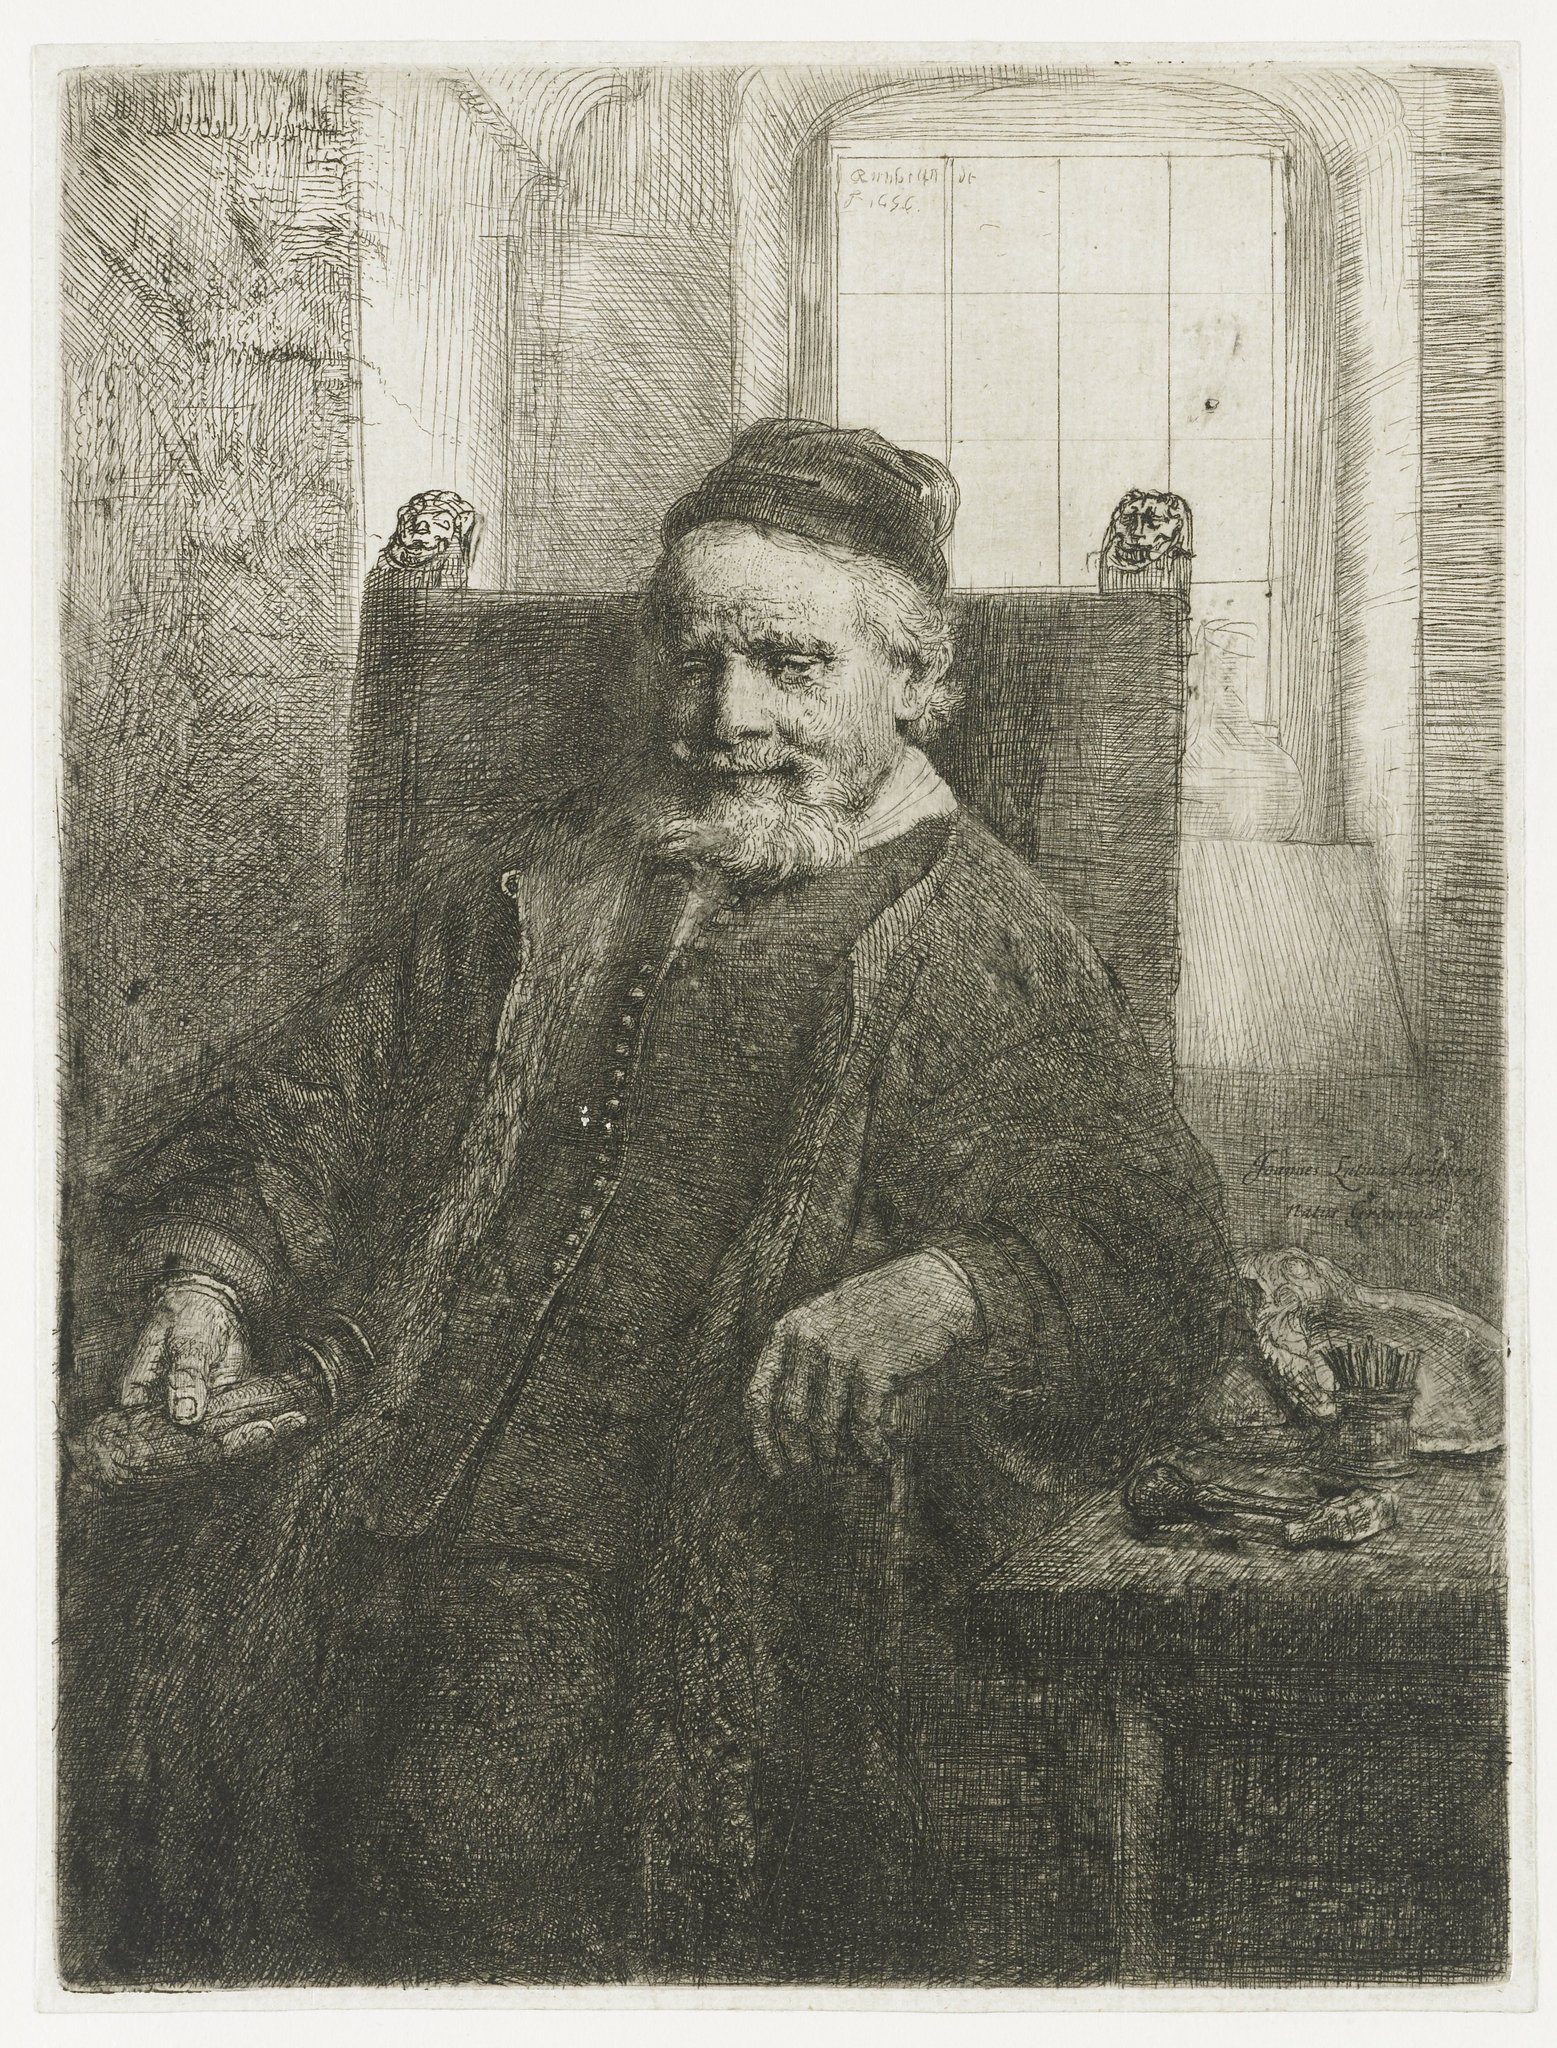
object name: print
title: Jan Lutma, goldsmith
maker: rembrandt van rijn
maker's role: draughtsman, painter, print maker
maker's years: 1606-1669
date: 1656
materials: paper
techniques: drypoint, etching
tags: amsterdam, print maker, draughtsman, silversmith, johannes lutma (1584-1669)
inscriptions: collector's mark: Lugt 2165, signature and date: ‘Rembrandt f 1656’